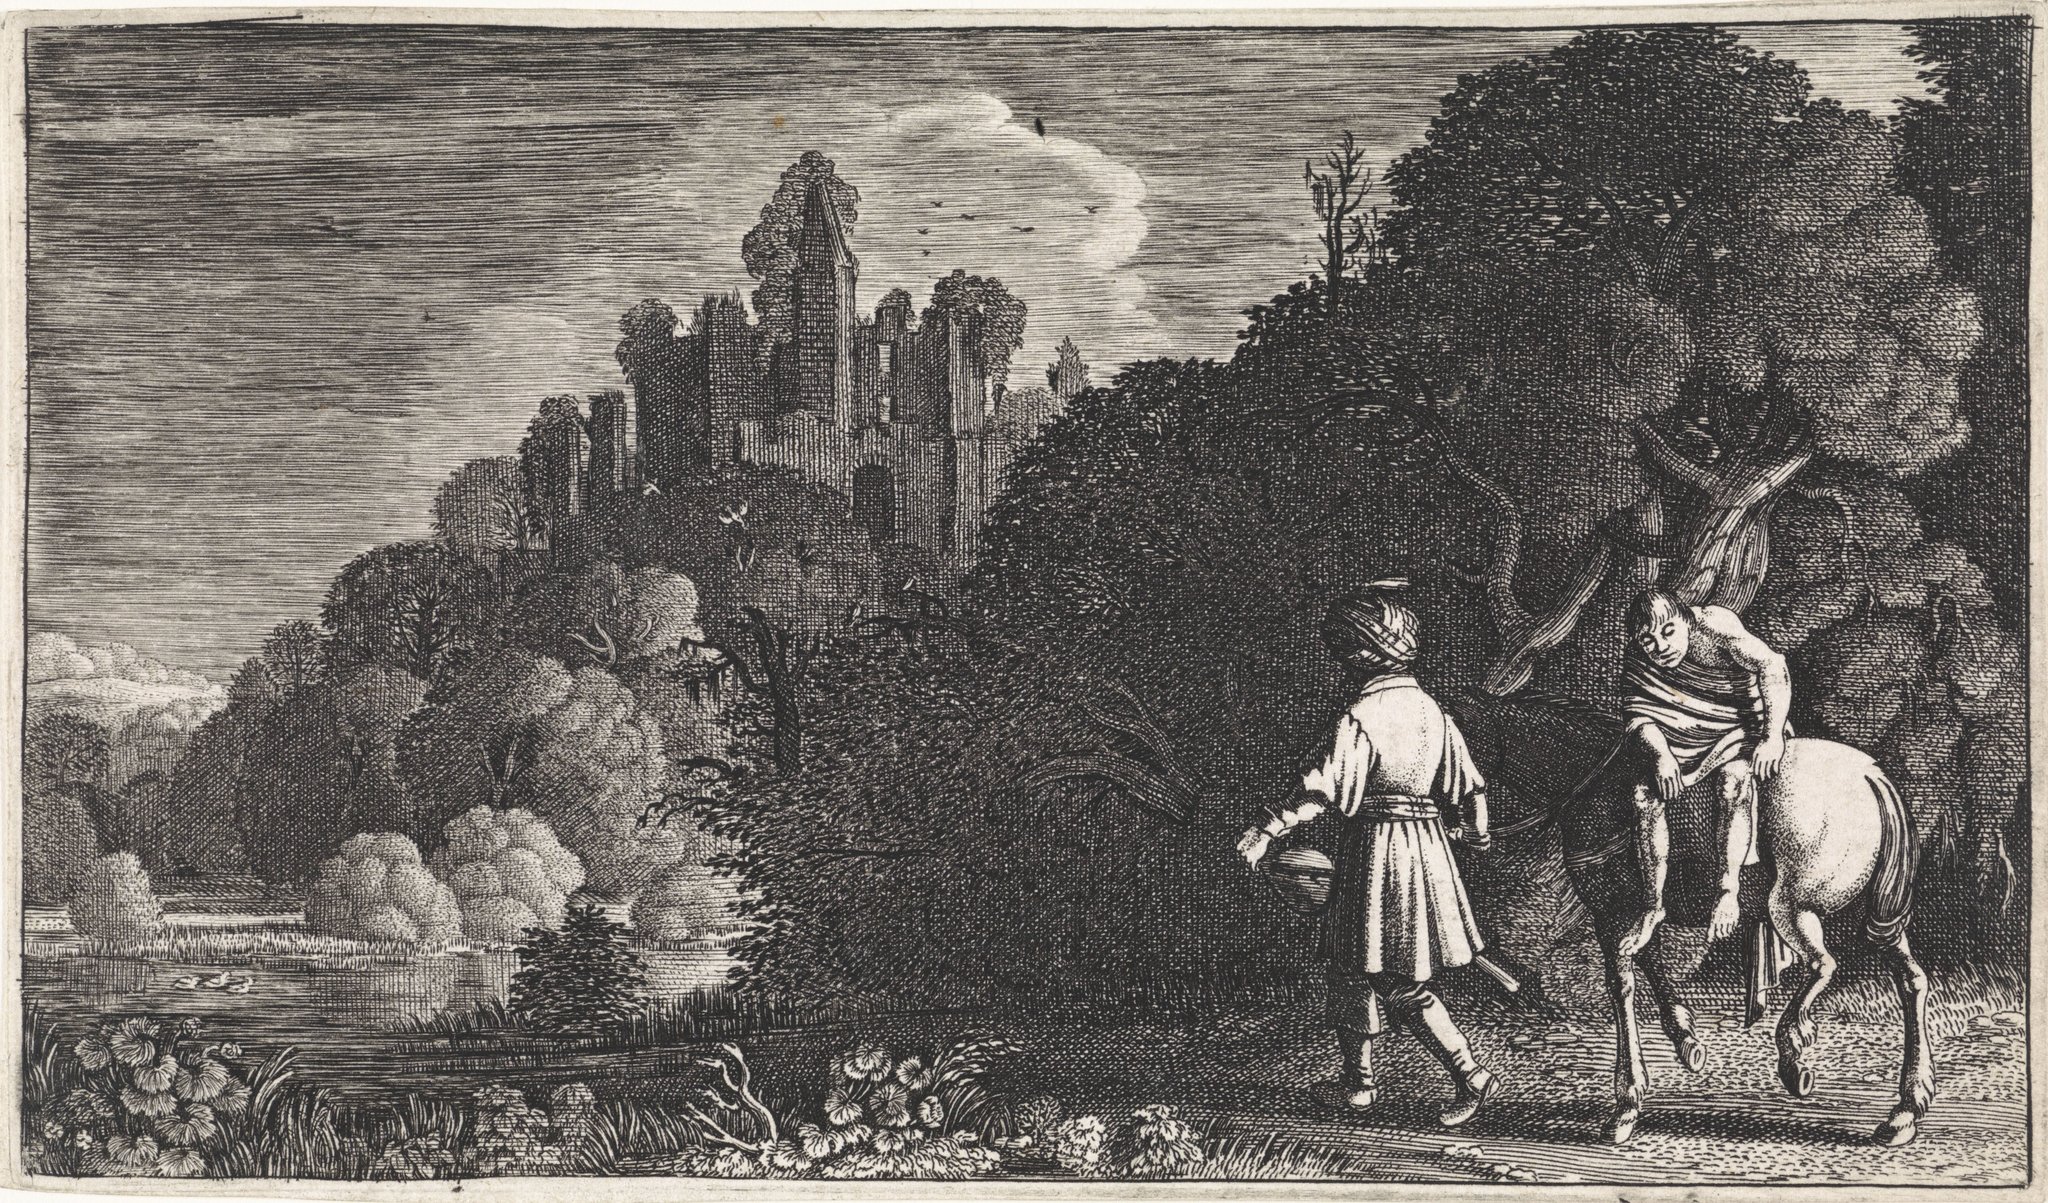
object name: print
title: Avond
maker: jan van de velde (ii)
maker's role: draughtsman, painter, print maker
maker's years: 1593-1641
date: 1603-1641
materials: paper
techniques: engraving, etching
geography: northern netherlands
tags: dusk, evening twilight, the samaritan sets the wounded traveller on his mount (ass or horse), and brings him to an inn, evening ~ landscape (sometimes titled 'vesper')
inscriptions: collector's mark: Lugt 240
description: De barmhartige Samaritaan voert de gewonde reiziger op zijn ezel door een donker landschap. Linksachter de ruïne van een kasteel op een heuvel. Prent uit een serie van vier.